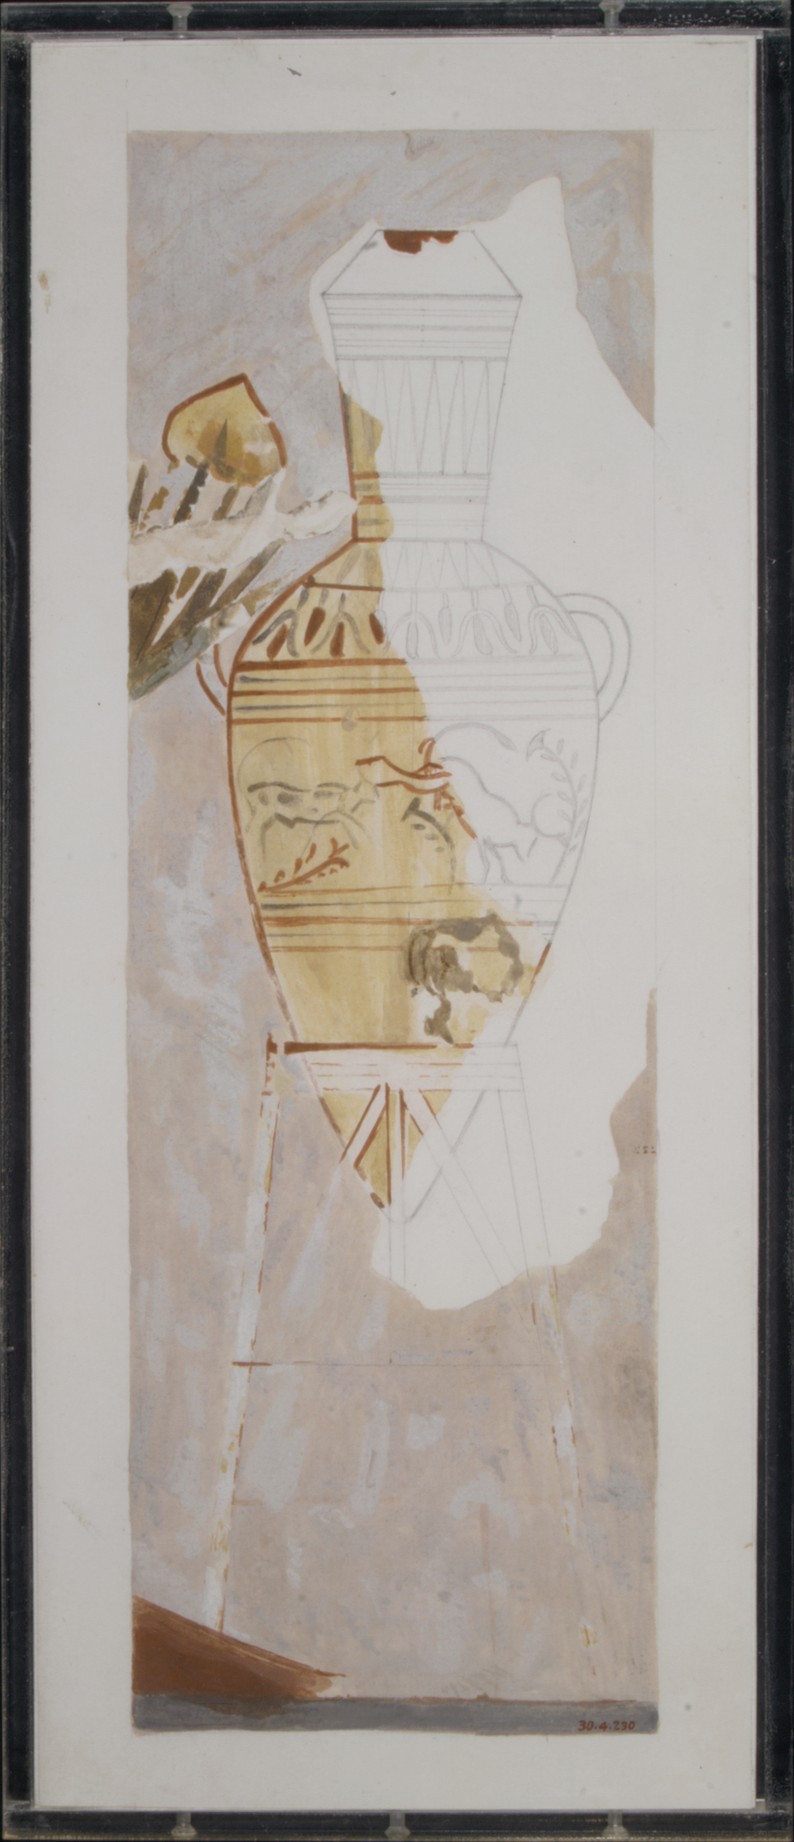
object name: facsimile, nakht tt 161, jar and stand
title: Jar and Stand, Tomb of Nakht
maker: charles k. wilkinson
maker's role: artist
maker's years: 1897-1986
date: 1390-1352 BCE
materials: paper, paint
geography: egypt